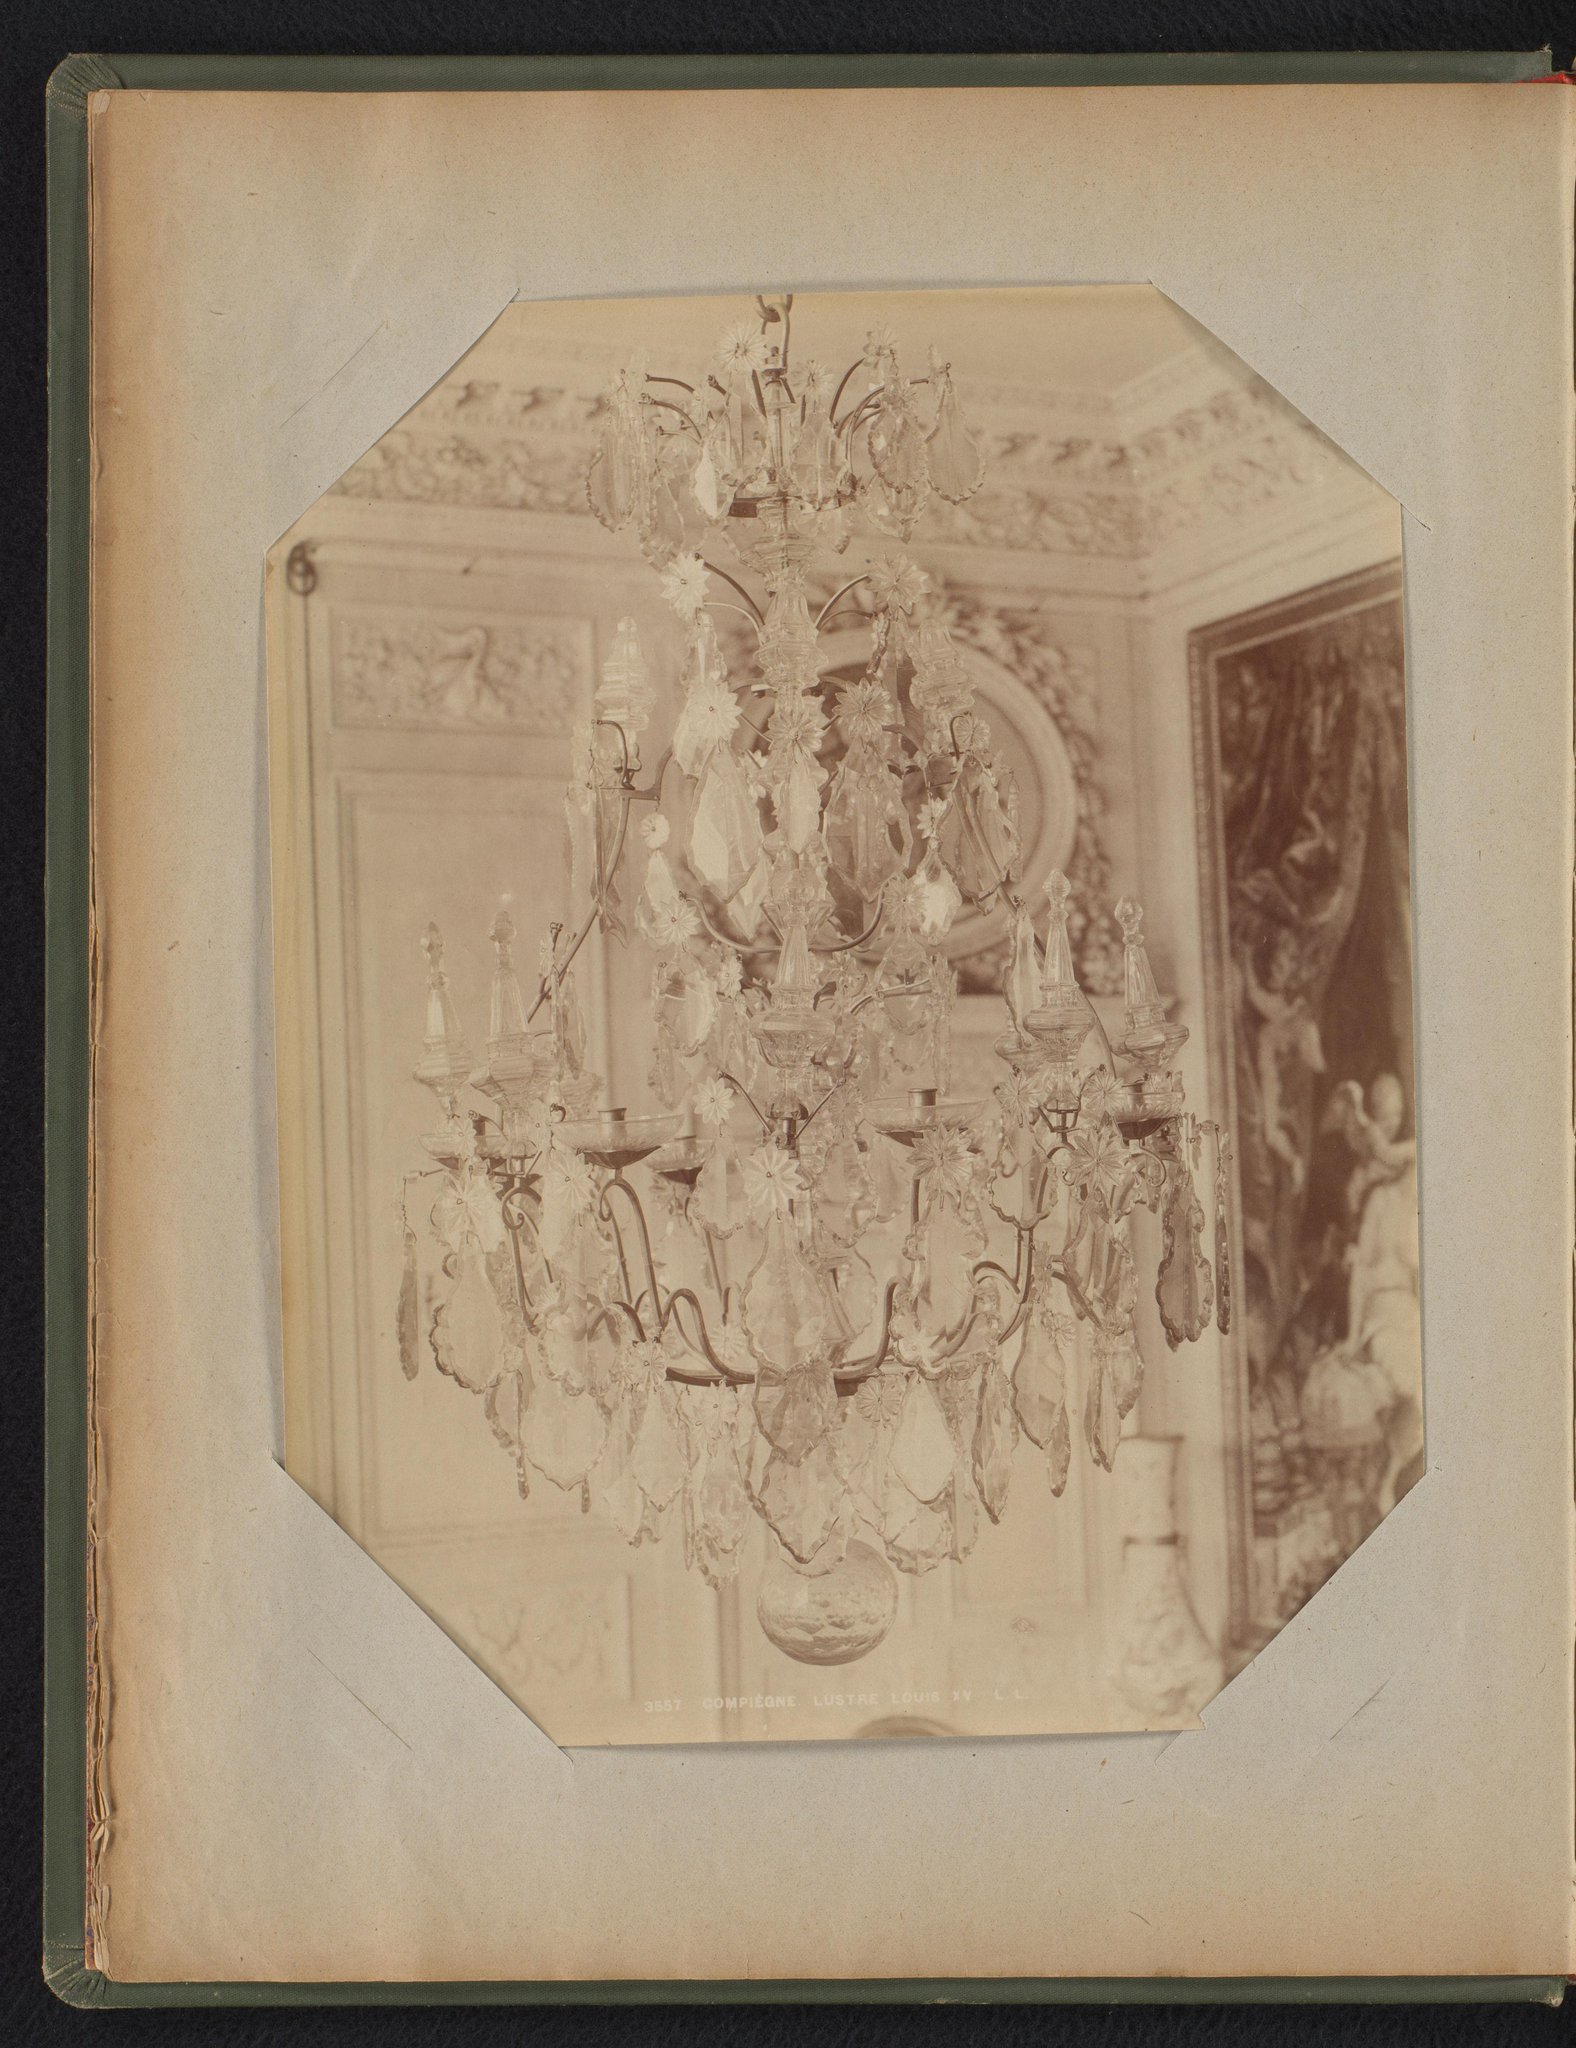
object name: photograph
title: Kroonluchter met kristallen ornamenten in paleis Versailles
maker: Anonymous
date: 1860-1900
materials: canvas, cardboard, paper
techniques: matte daylight collodion silver print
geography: netherlands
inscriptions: annotation: ‘3557 Compiegne lustre Louis XV L.L.’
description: Onderdeel van een serie met betrekking tot het interieur van het paleis van Versailles met kroonluchters, deuren, portalen en meubelstukken.